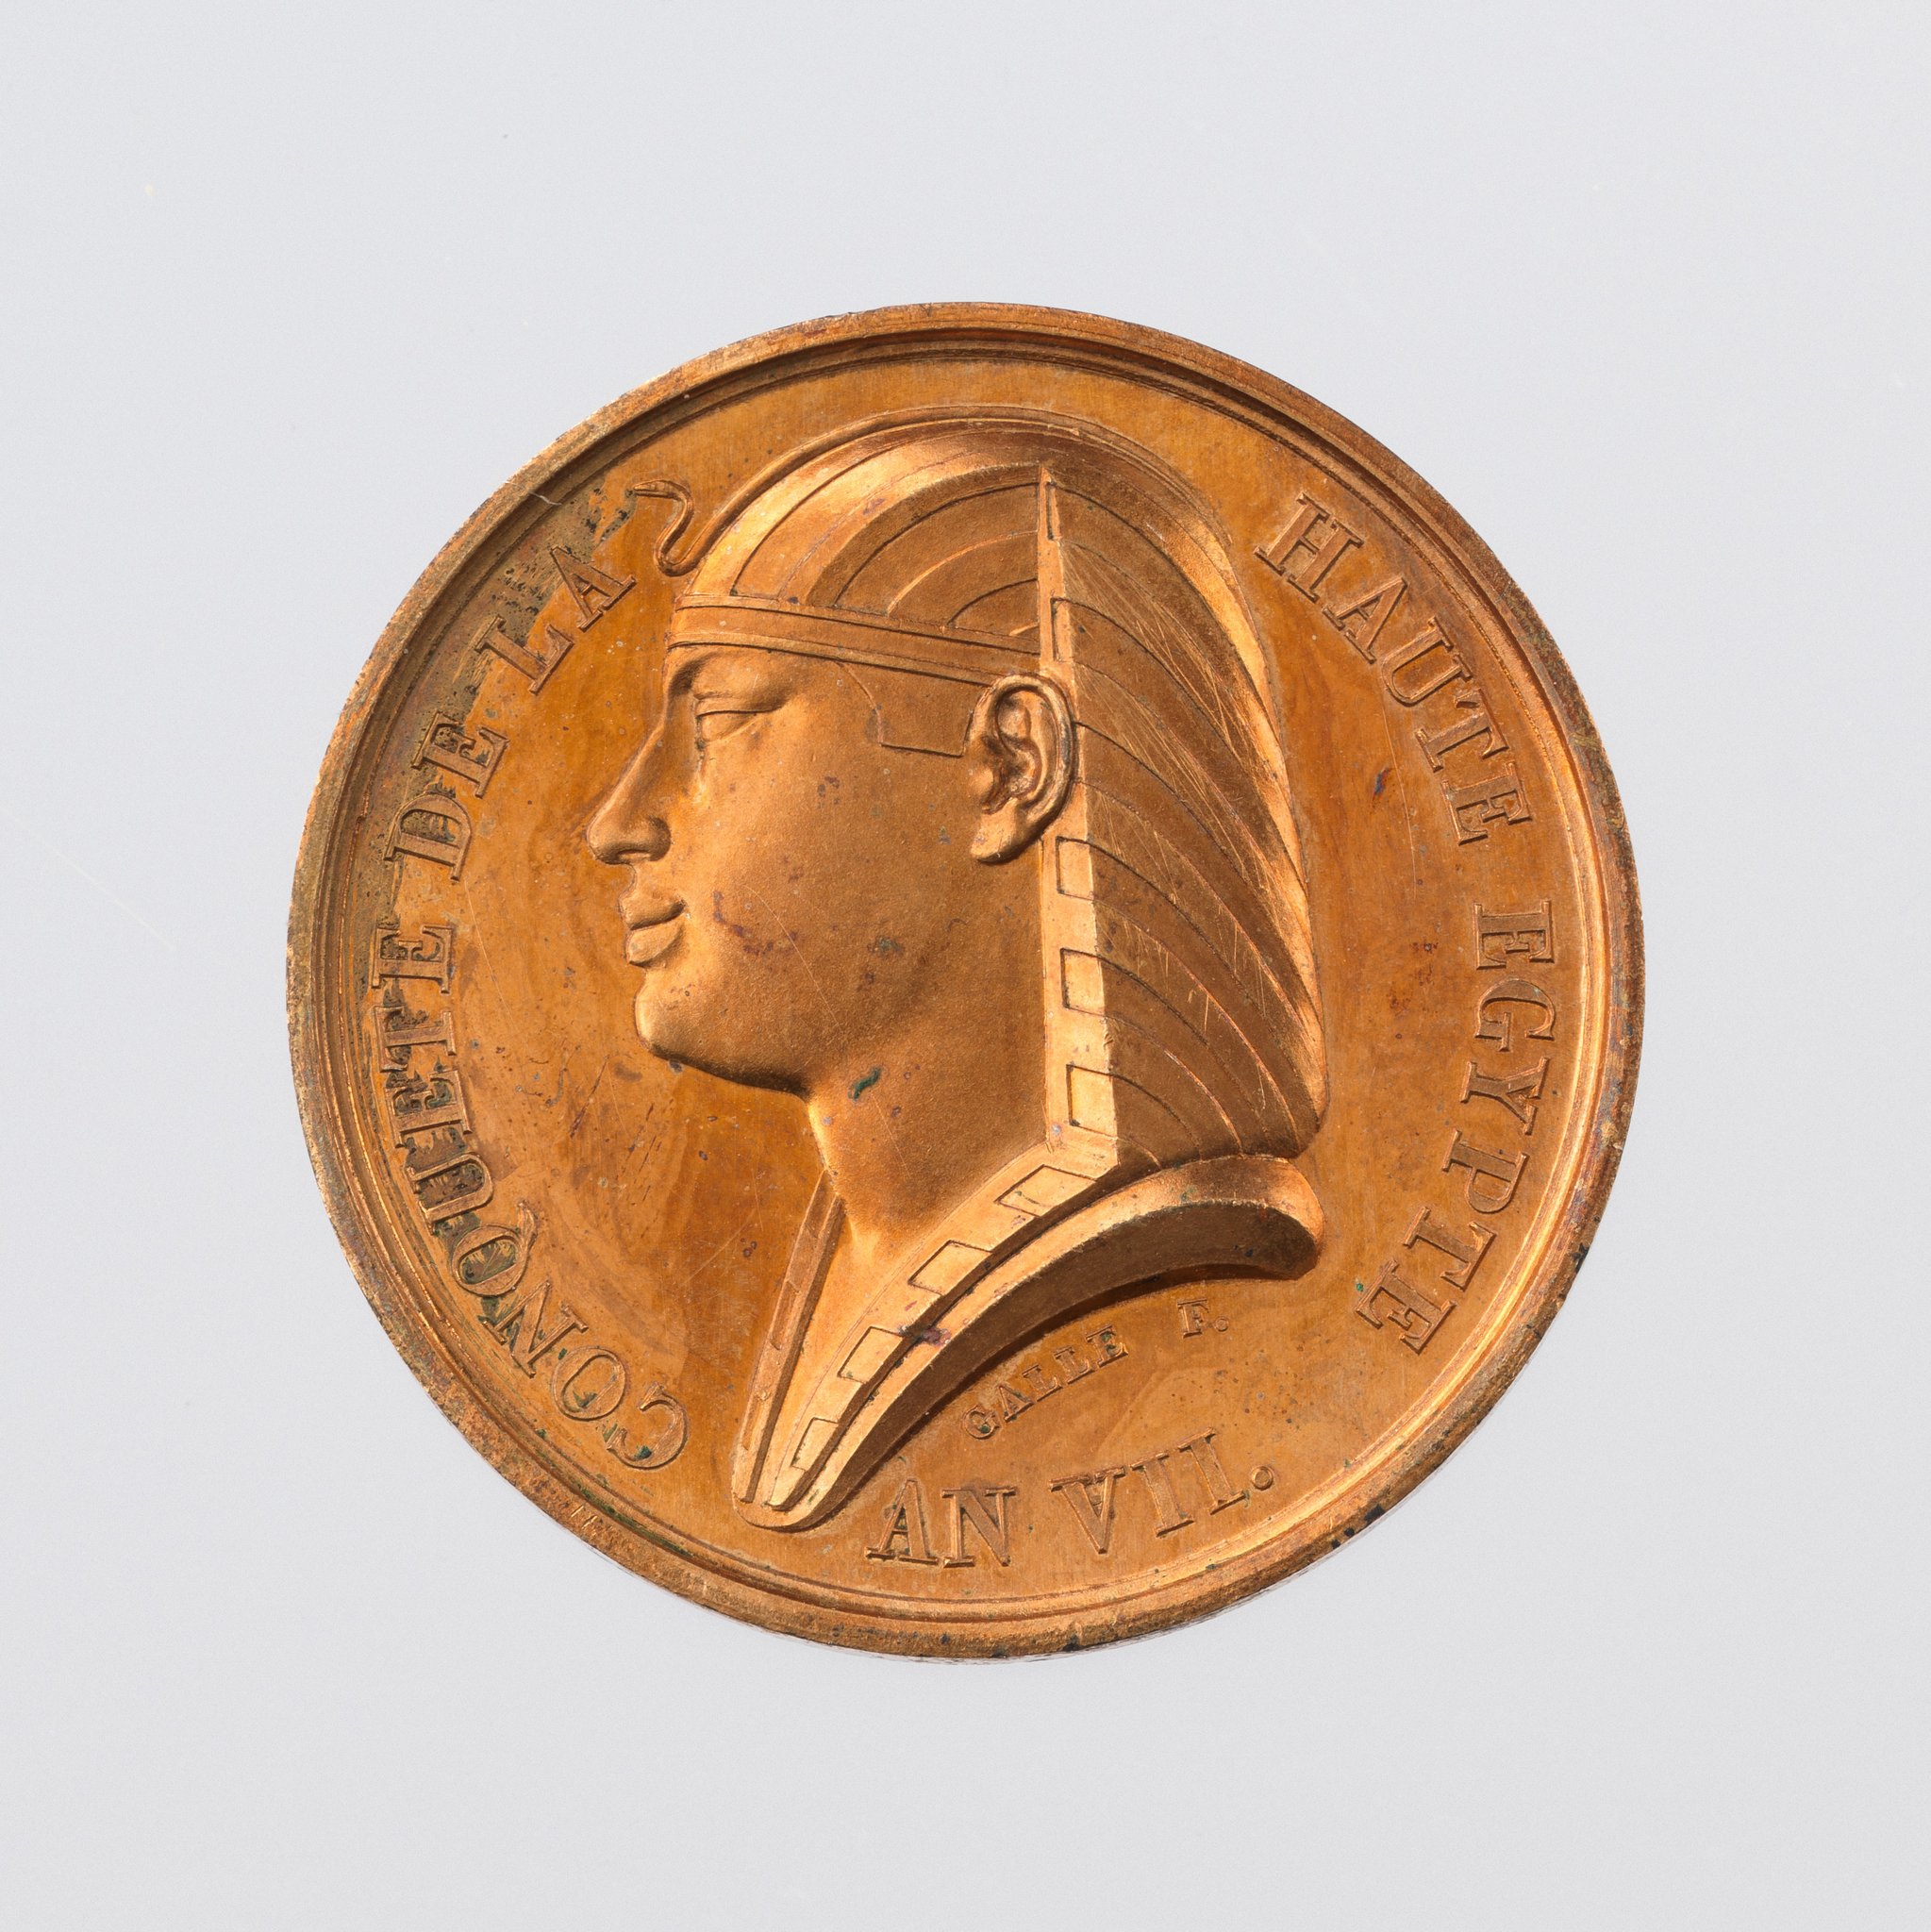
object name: medal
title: Conquest of Upper Egypt, 1798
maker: andré galle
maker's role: artist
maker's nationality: french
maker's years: 1761-1844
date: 1798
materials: gilt bronze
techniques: struck